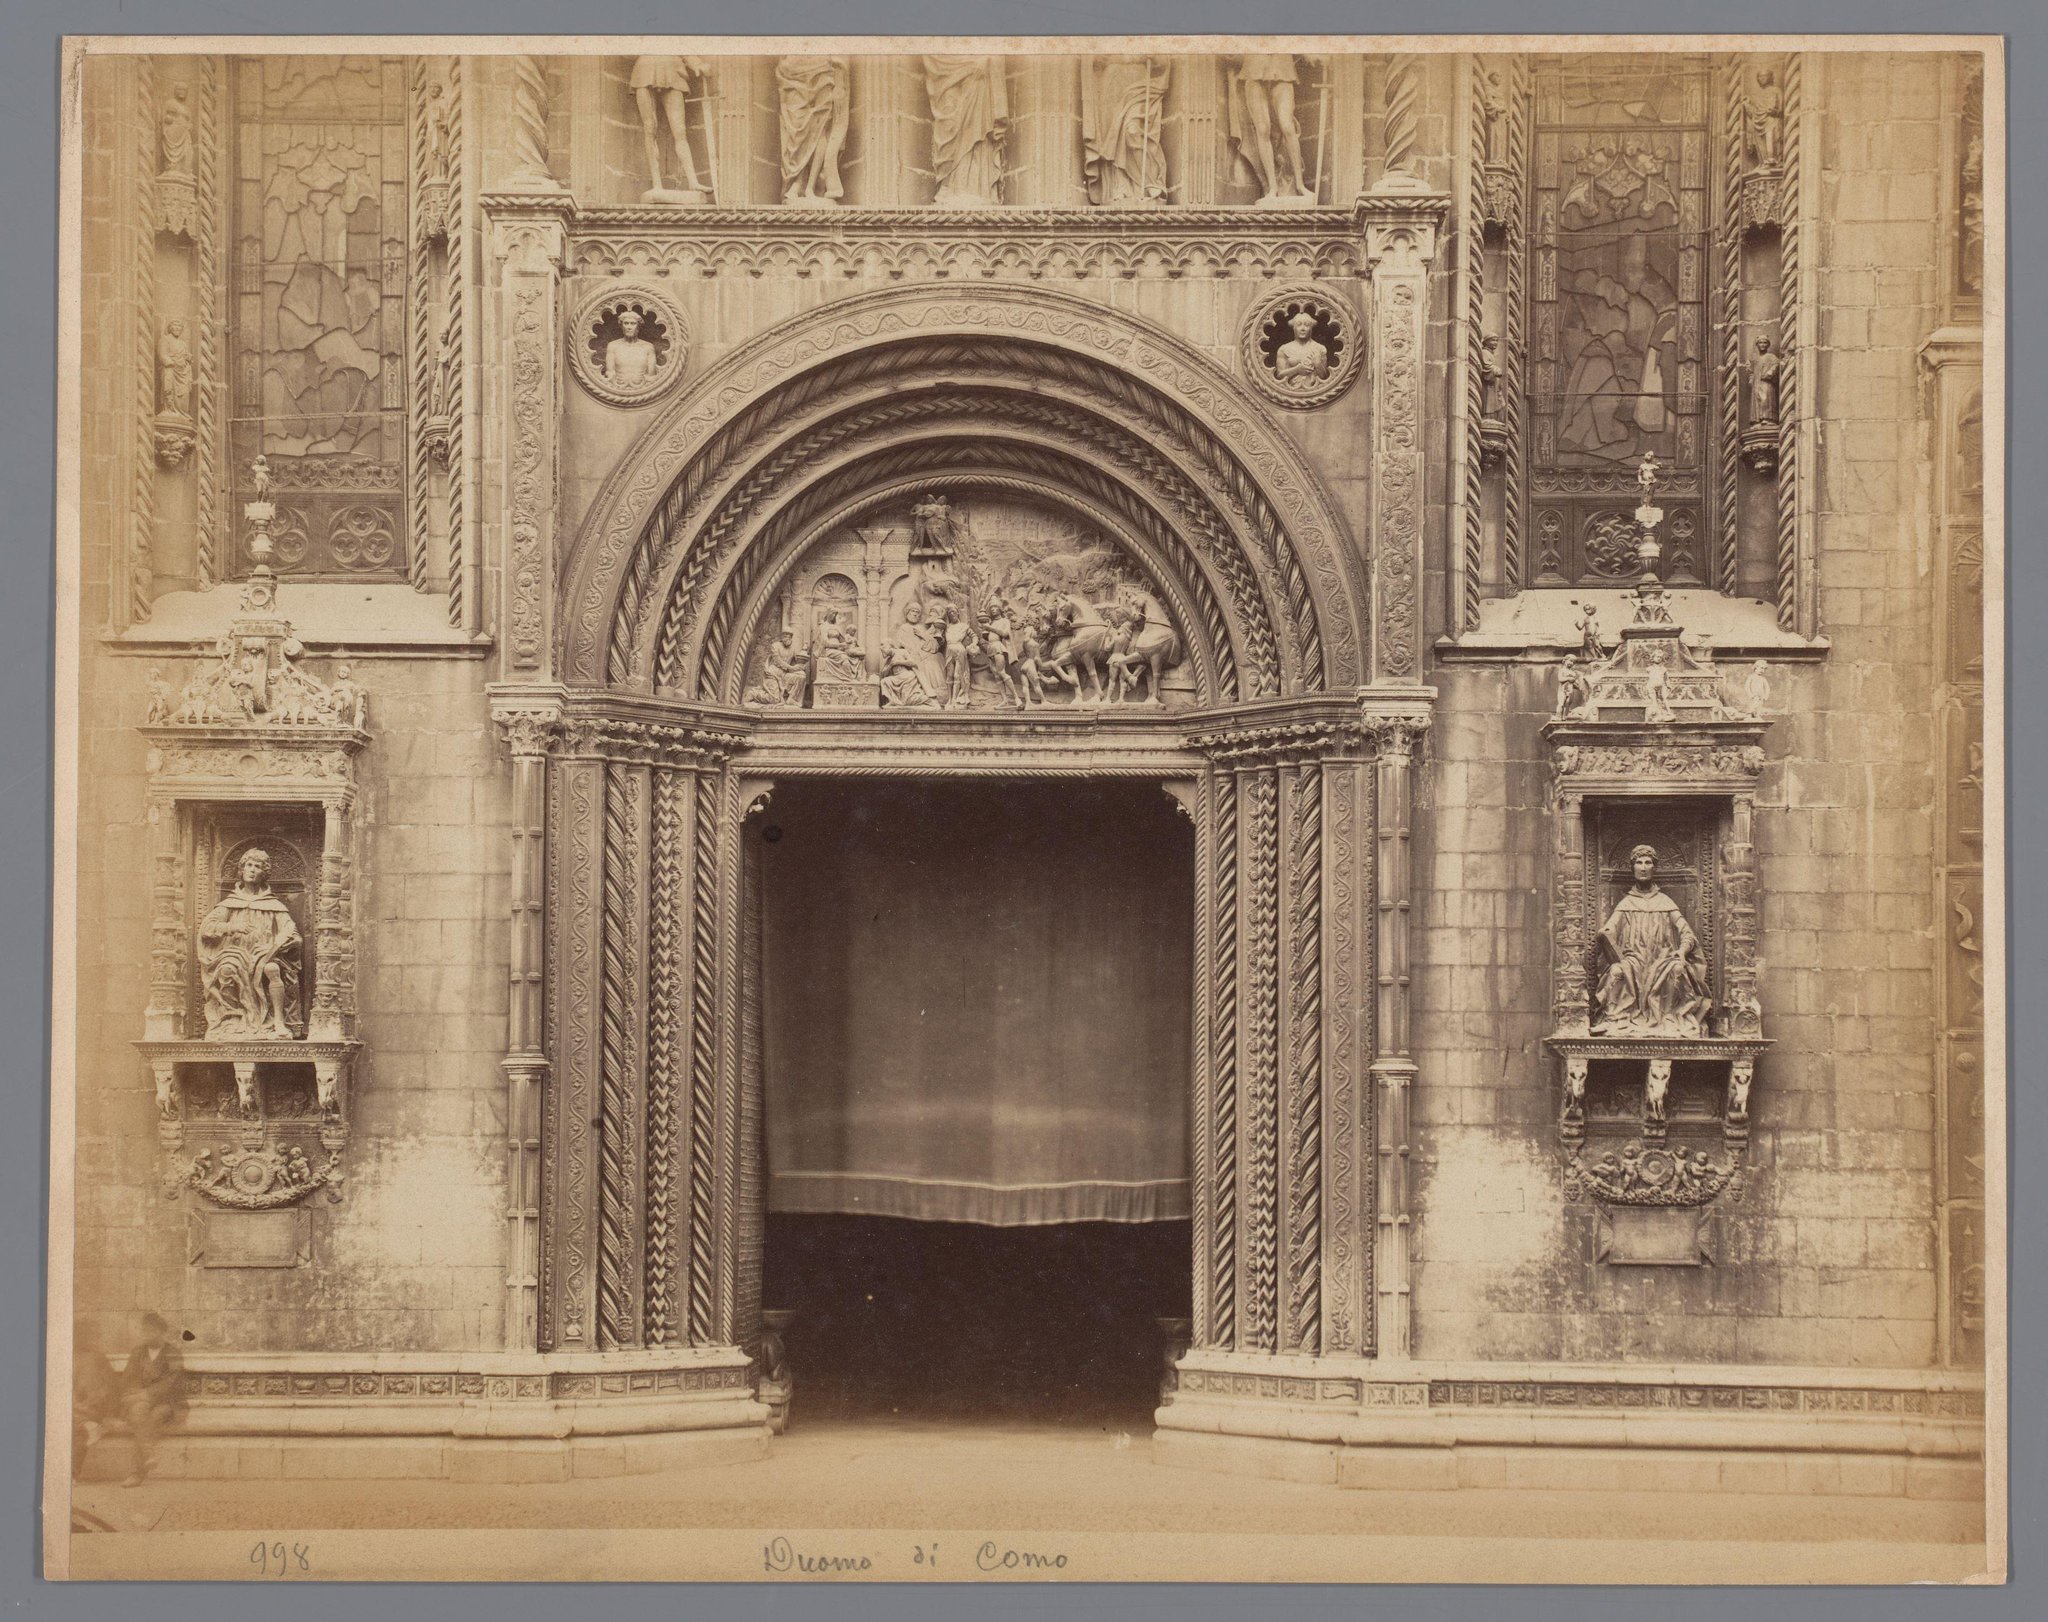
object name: photograph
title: Duomo di Como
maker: Anonymous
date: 1851-1900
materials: cardboard, paper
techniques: albumen print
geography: como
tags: parts of church exterior and annexes: portal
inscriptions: number: ‘998’